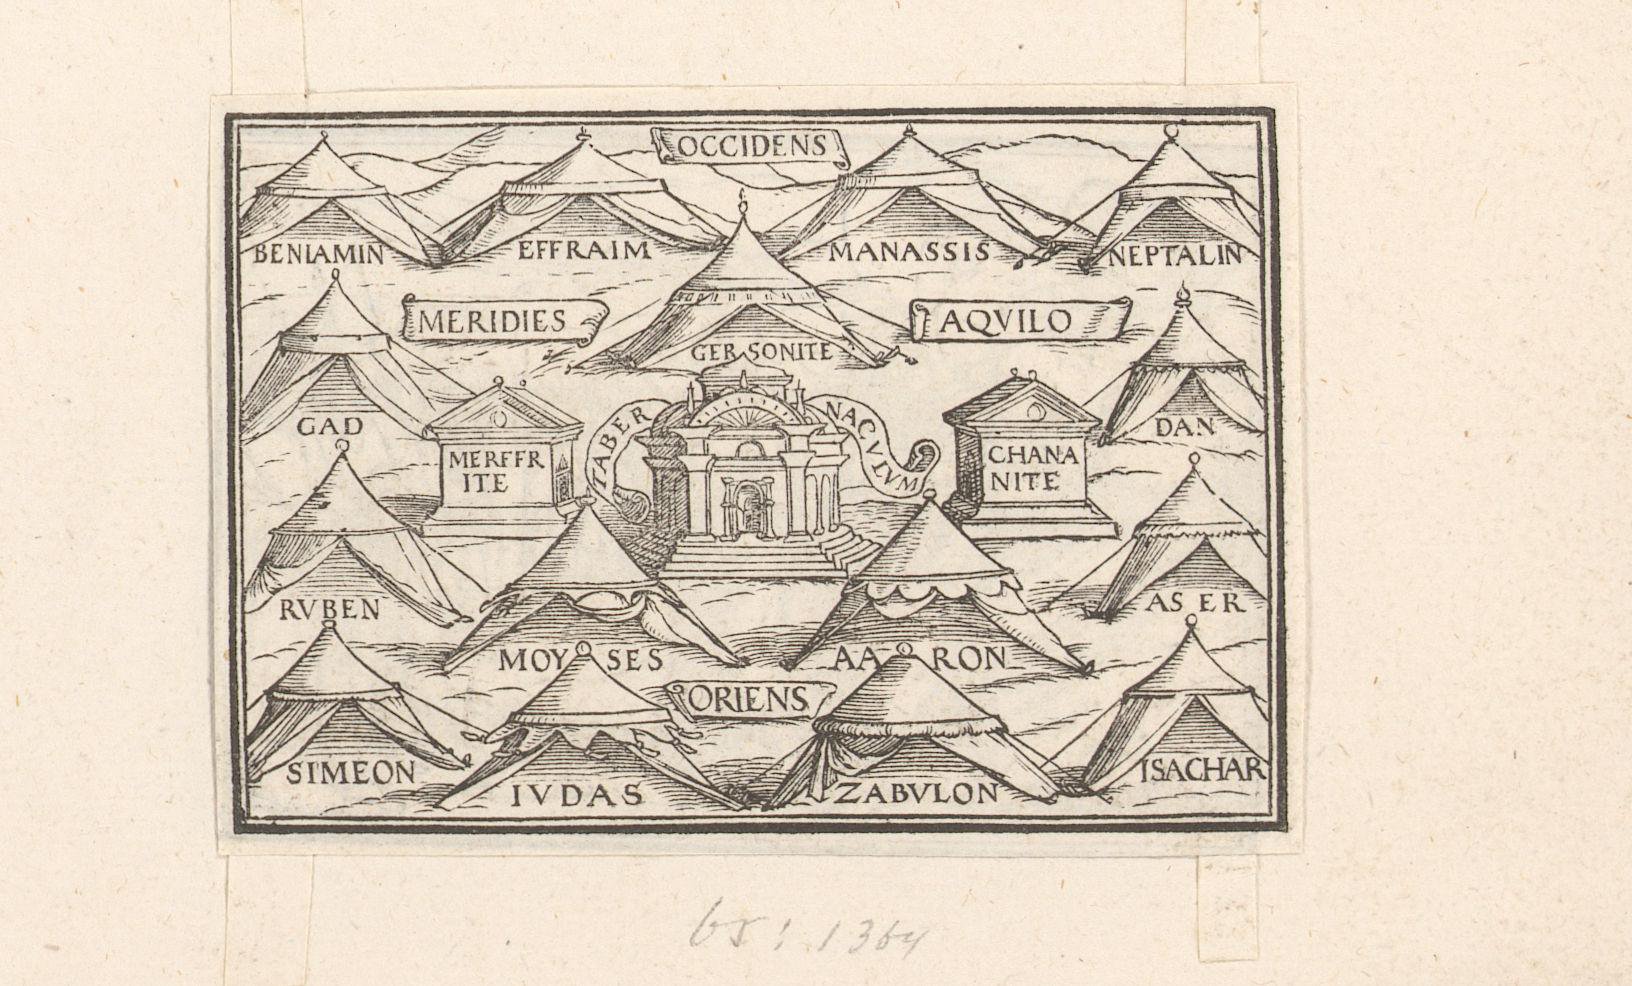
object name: album leaf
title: Geschiedenis van het Oude Testament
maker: veit rudolf specklin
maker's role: print maker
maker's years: -1550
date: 1538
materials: paper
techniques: woodcut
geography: switzerland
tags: the tribes are arranged in their proper order ~ the book of numbers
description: Boekillustratie voor het eerst gebruikt in: Biblia Utriusque Testamenti iuxta Vulgatam Translationem, Lyon, M. en G. Trechsel (voor Hugo à Porta) 1538. Later in verschillende uitgaven opnieuw gebruikt. Deze prent vermoedelijk gebruikt in één van de uitgaven uitgegeven en/of gedrukt door Jean Frellon, Lyon.